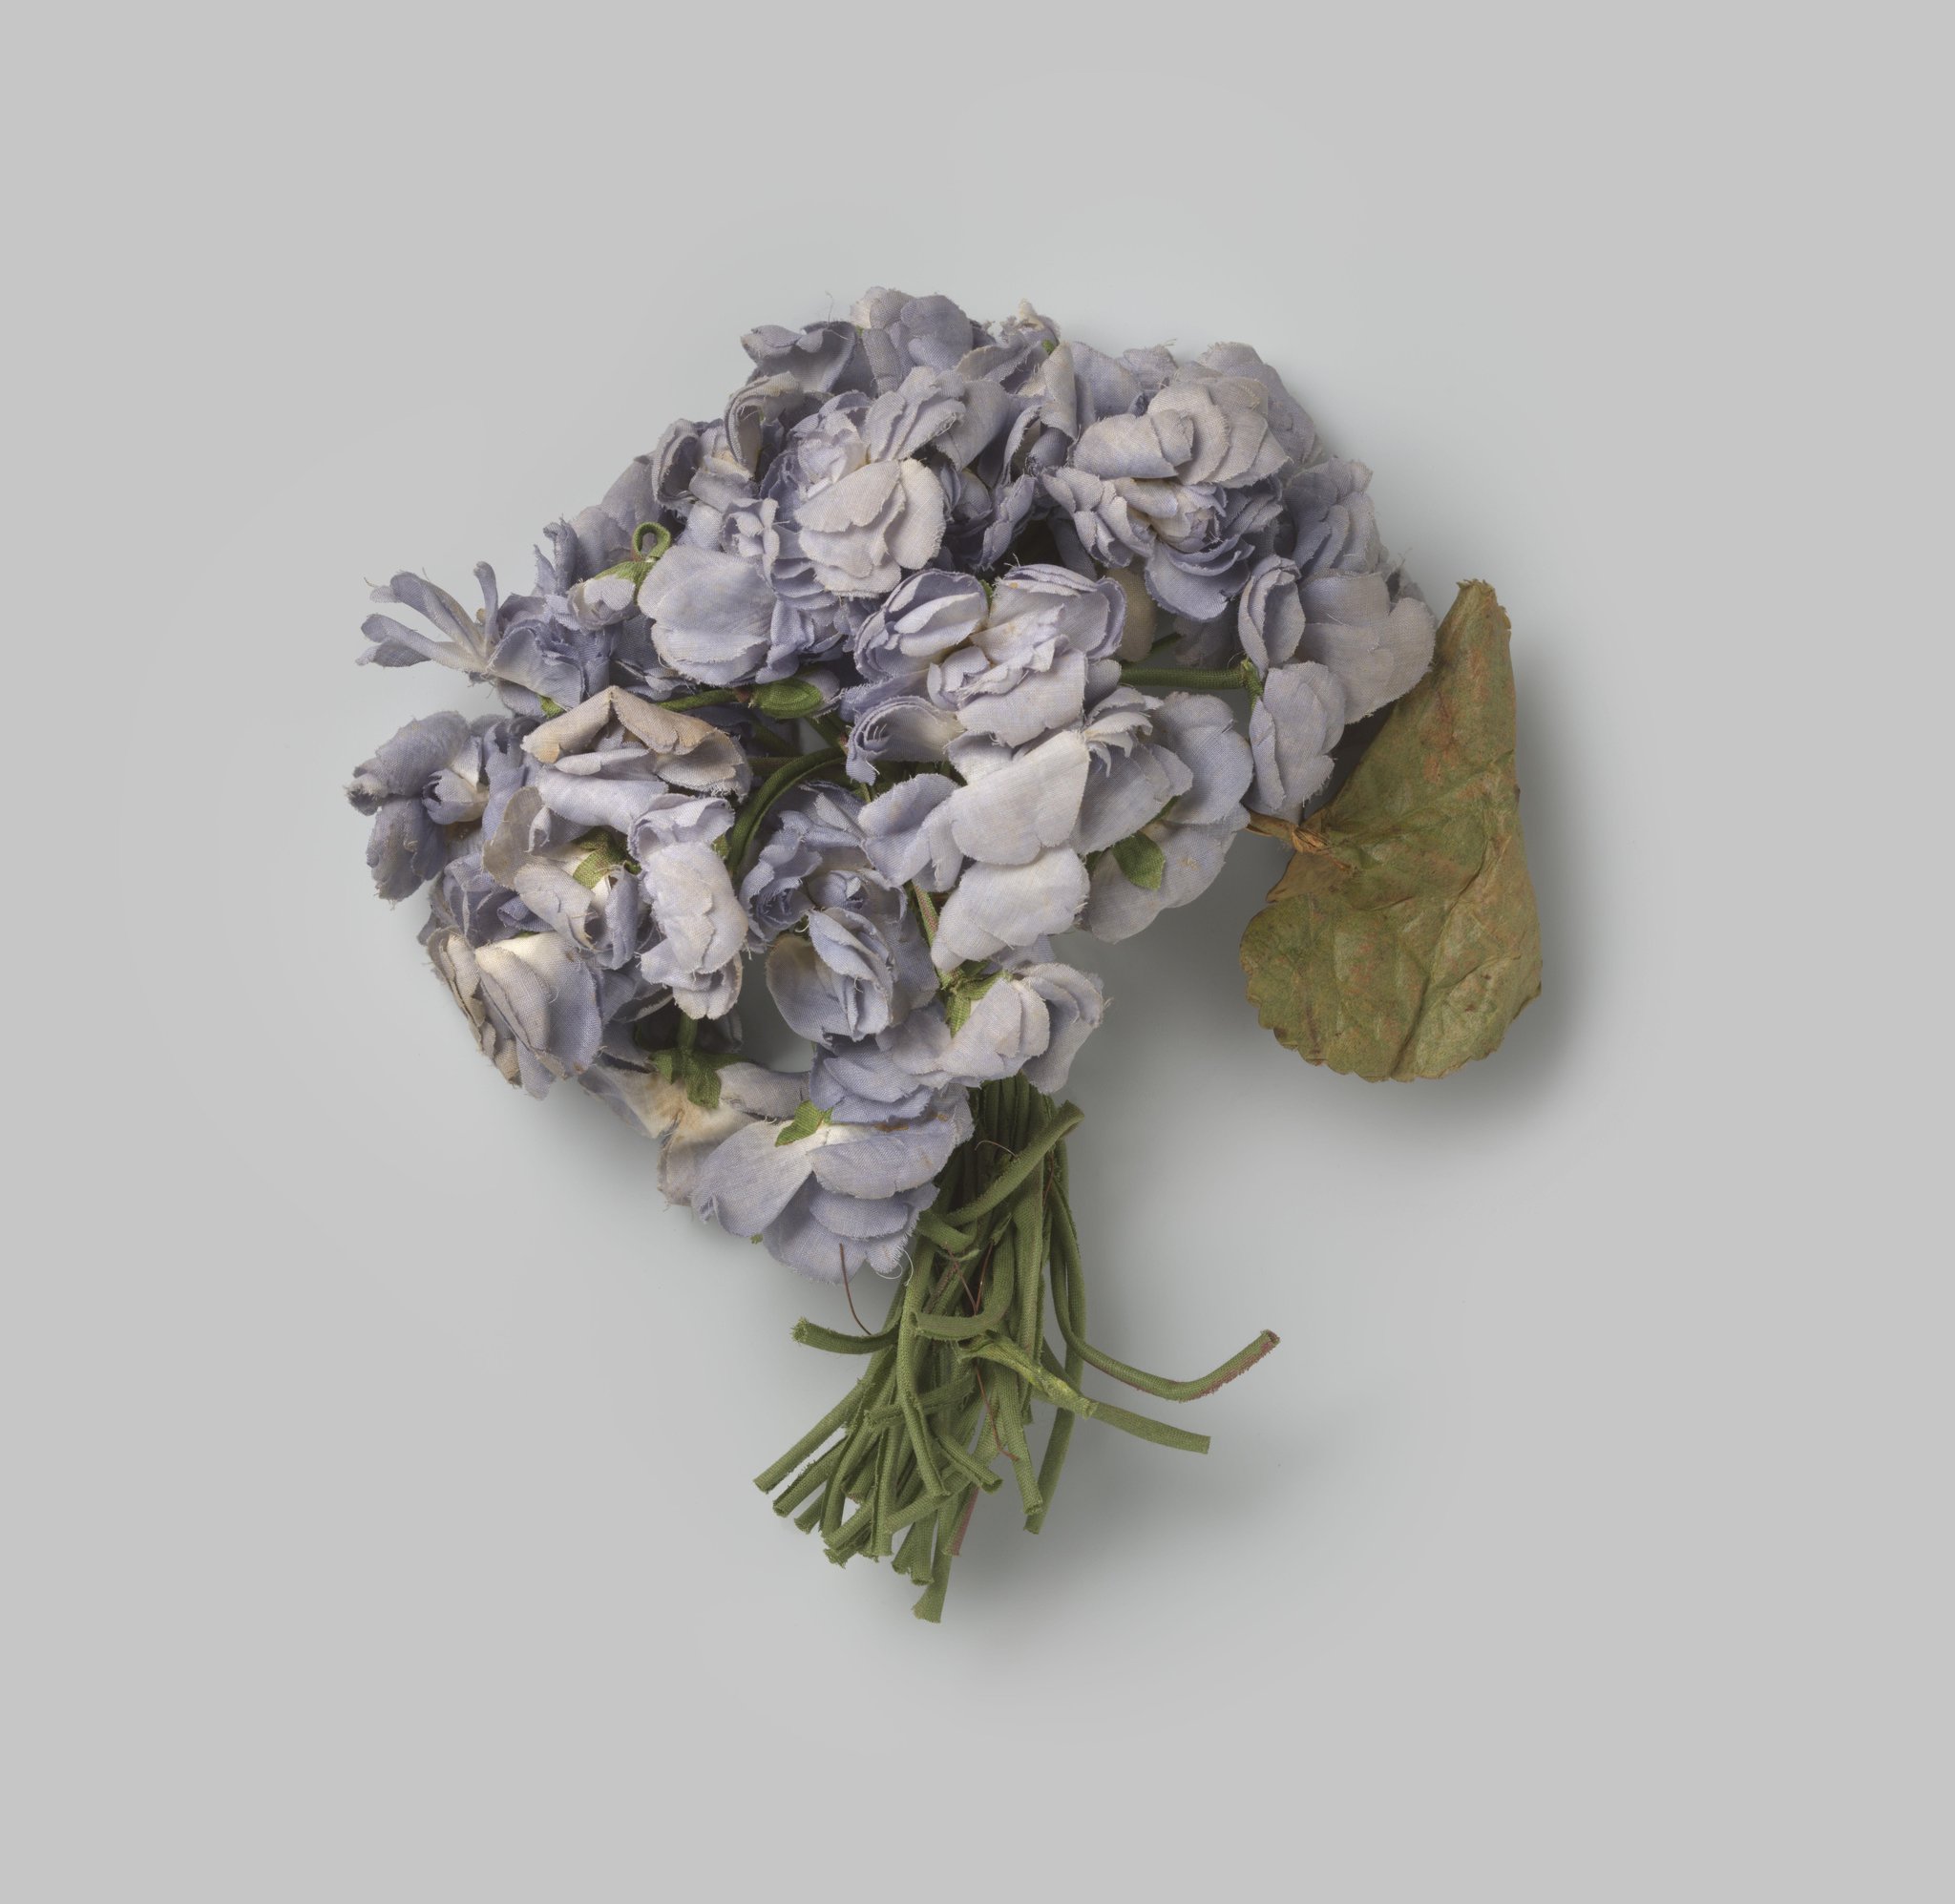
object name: corsage costume accessory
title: Corsage in de vorm van een toef lila seringen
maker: Anonymous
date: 1900-1950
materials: textile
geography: europe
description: Verzameling cortages, vier van stof, één van kunststof. D. seringen.